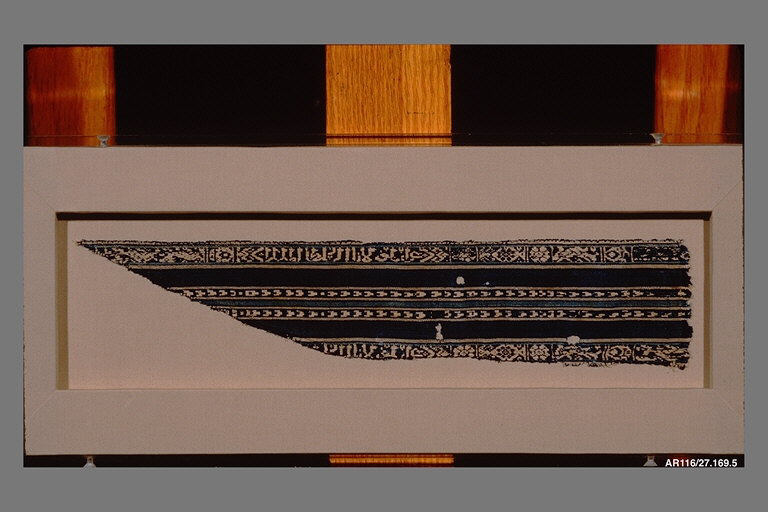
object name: textile fragment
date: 1101-1400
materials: cotton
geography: egypt